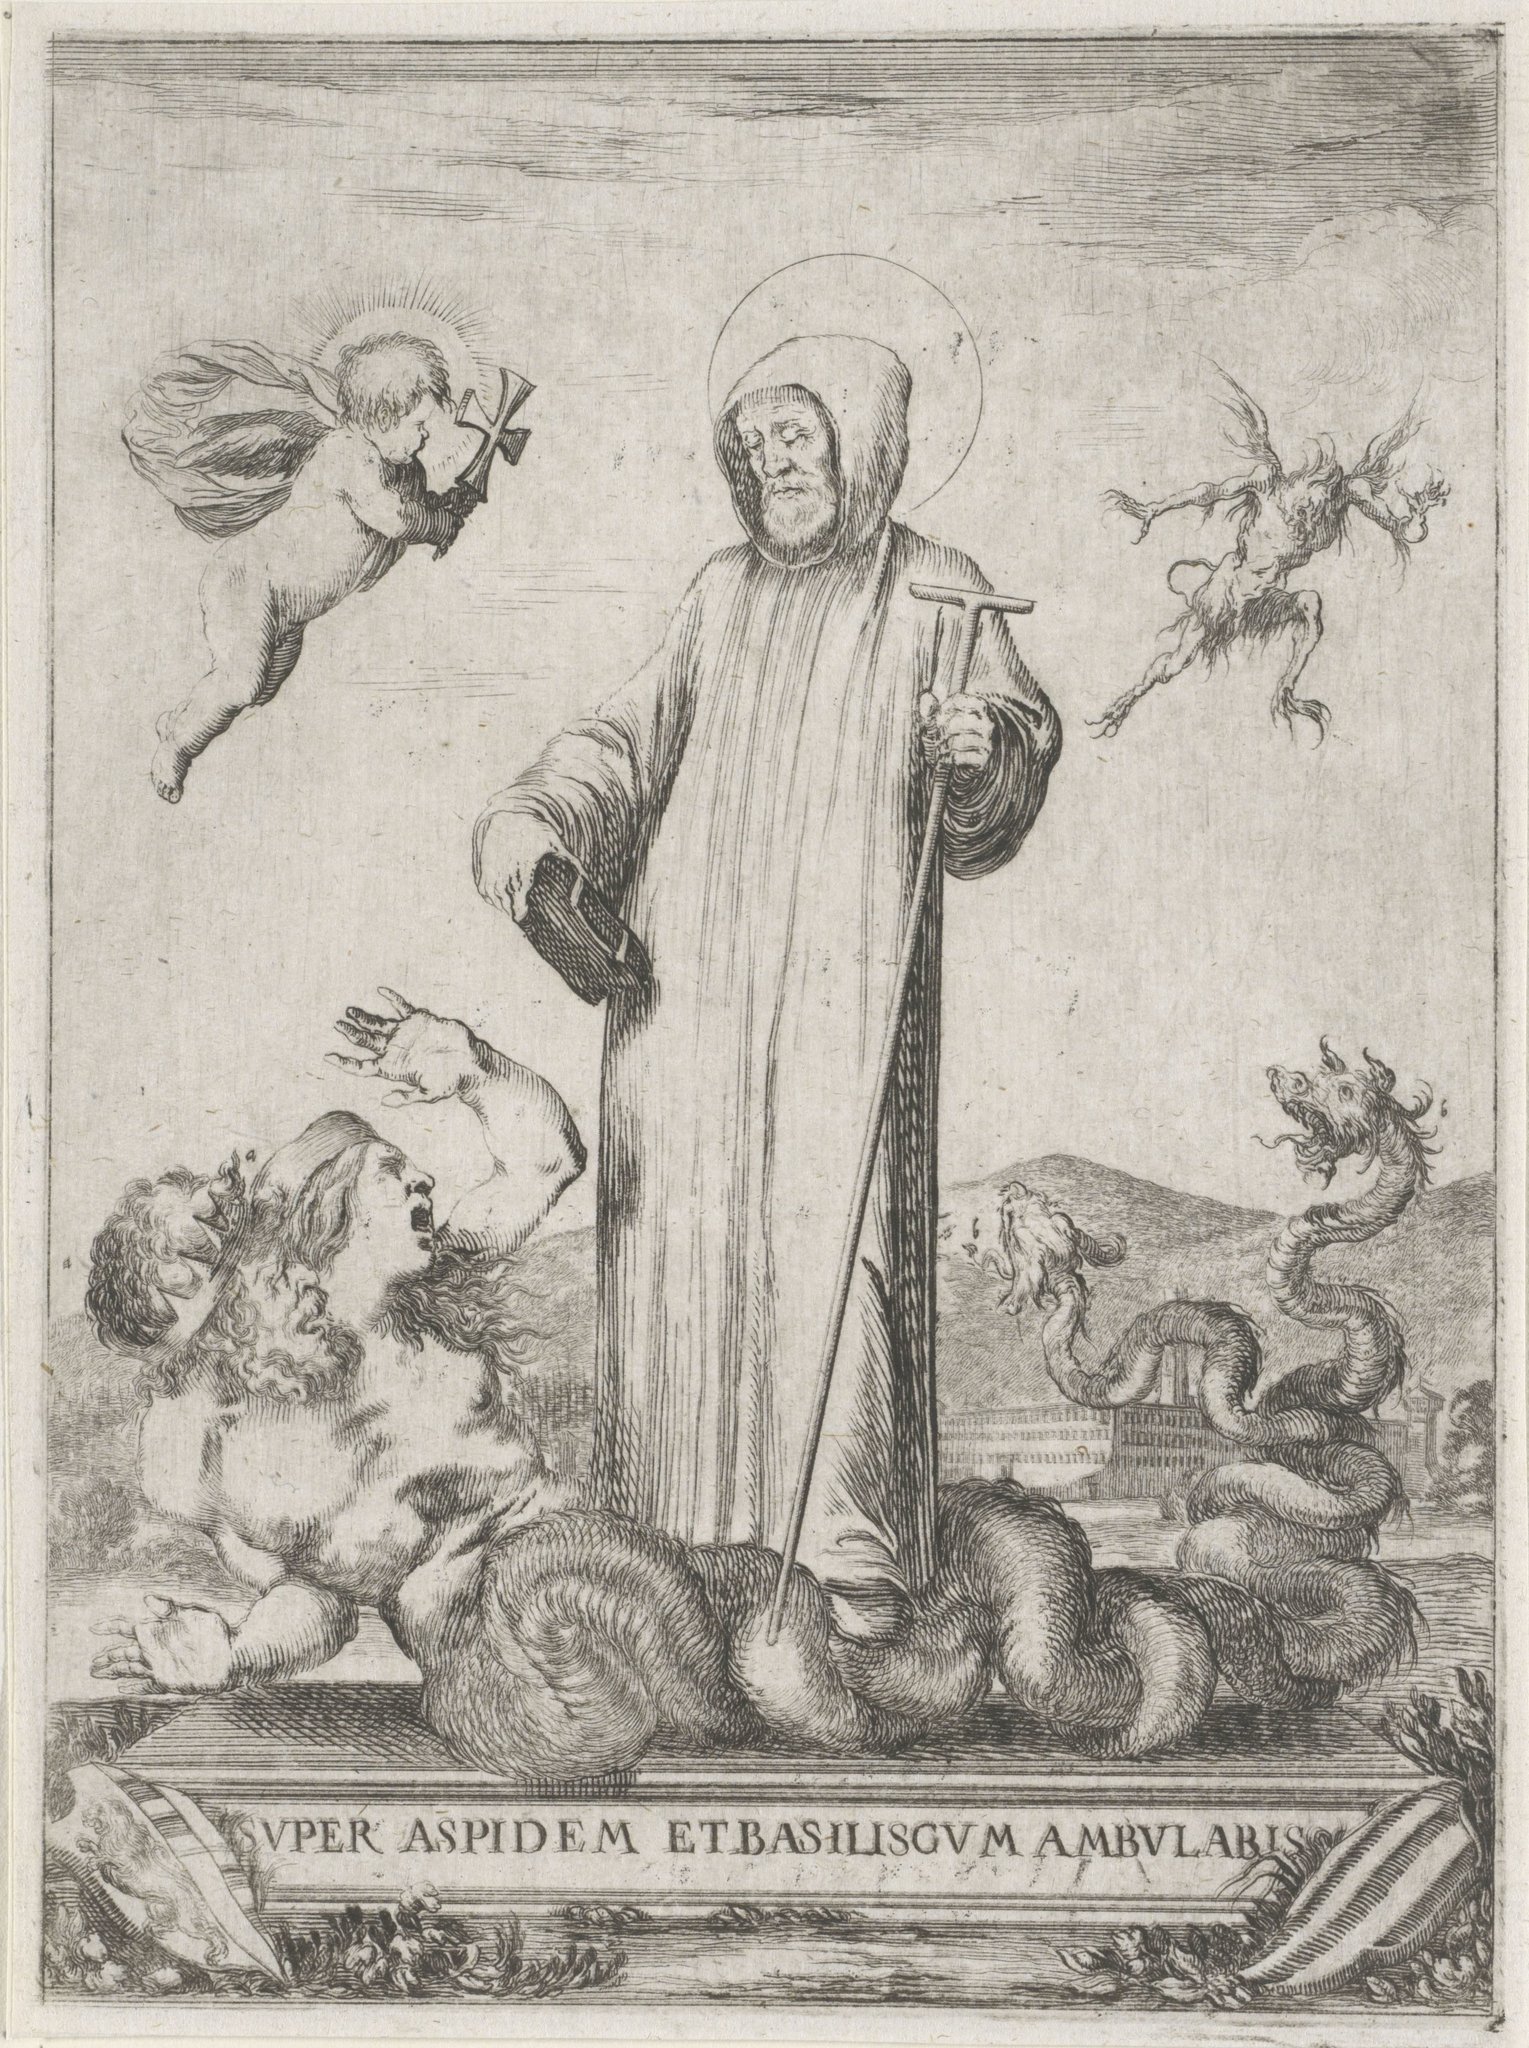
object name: print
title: Leven van de heilige Johannes Gualbertus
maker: stefano della bella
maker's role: draughtsman, print maker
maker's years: 1610-1664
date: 1620-1664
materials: paper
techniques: etching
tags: john gualberto, the benedictine monk, founder of the order of vallombrosa; possible attributes: book, crucifix, devil (or heretic) under foot, t-shaped staff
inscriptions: collector's mark: Lugt 240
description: De heilige Johannes Gualbertus staand met een tau-staf en een bijbel. Met zijn voet vertrapt hij een monsterlijk wezen met twee mensenhoofden en een staart met twee drakenkoppen. Links zweeft een engel met een kruis, rechts een duivels wezen.